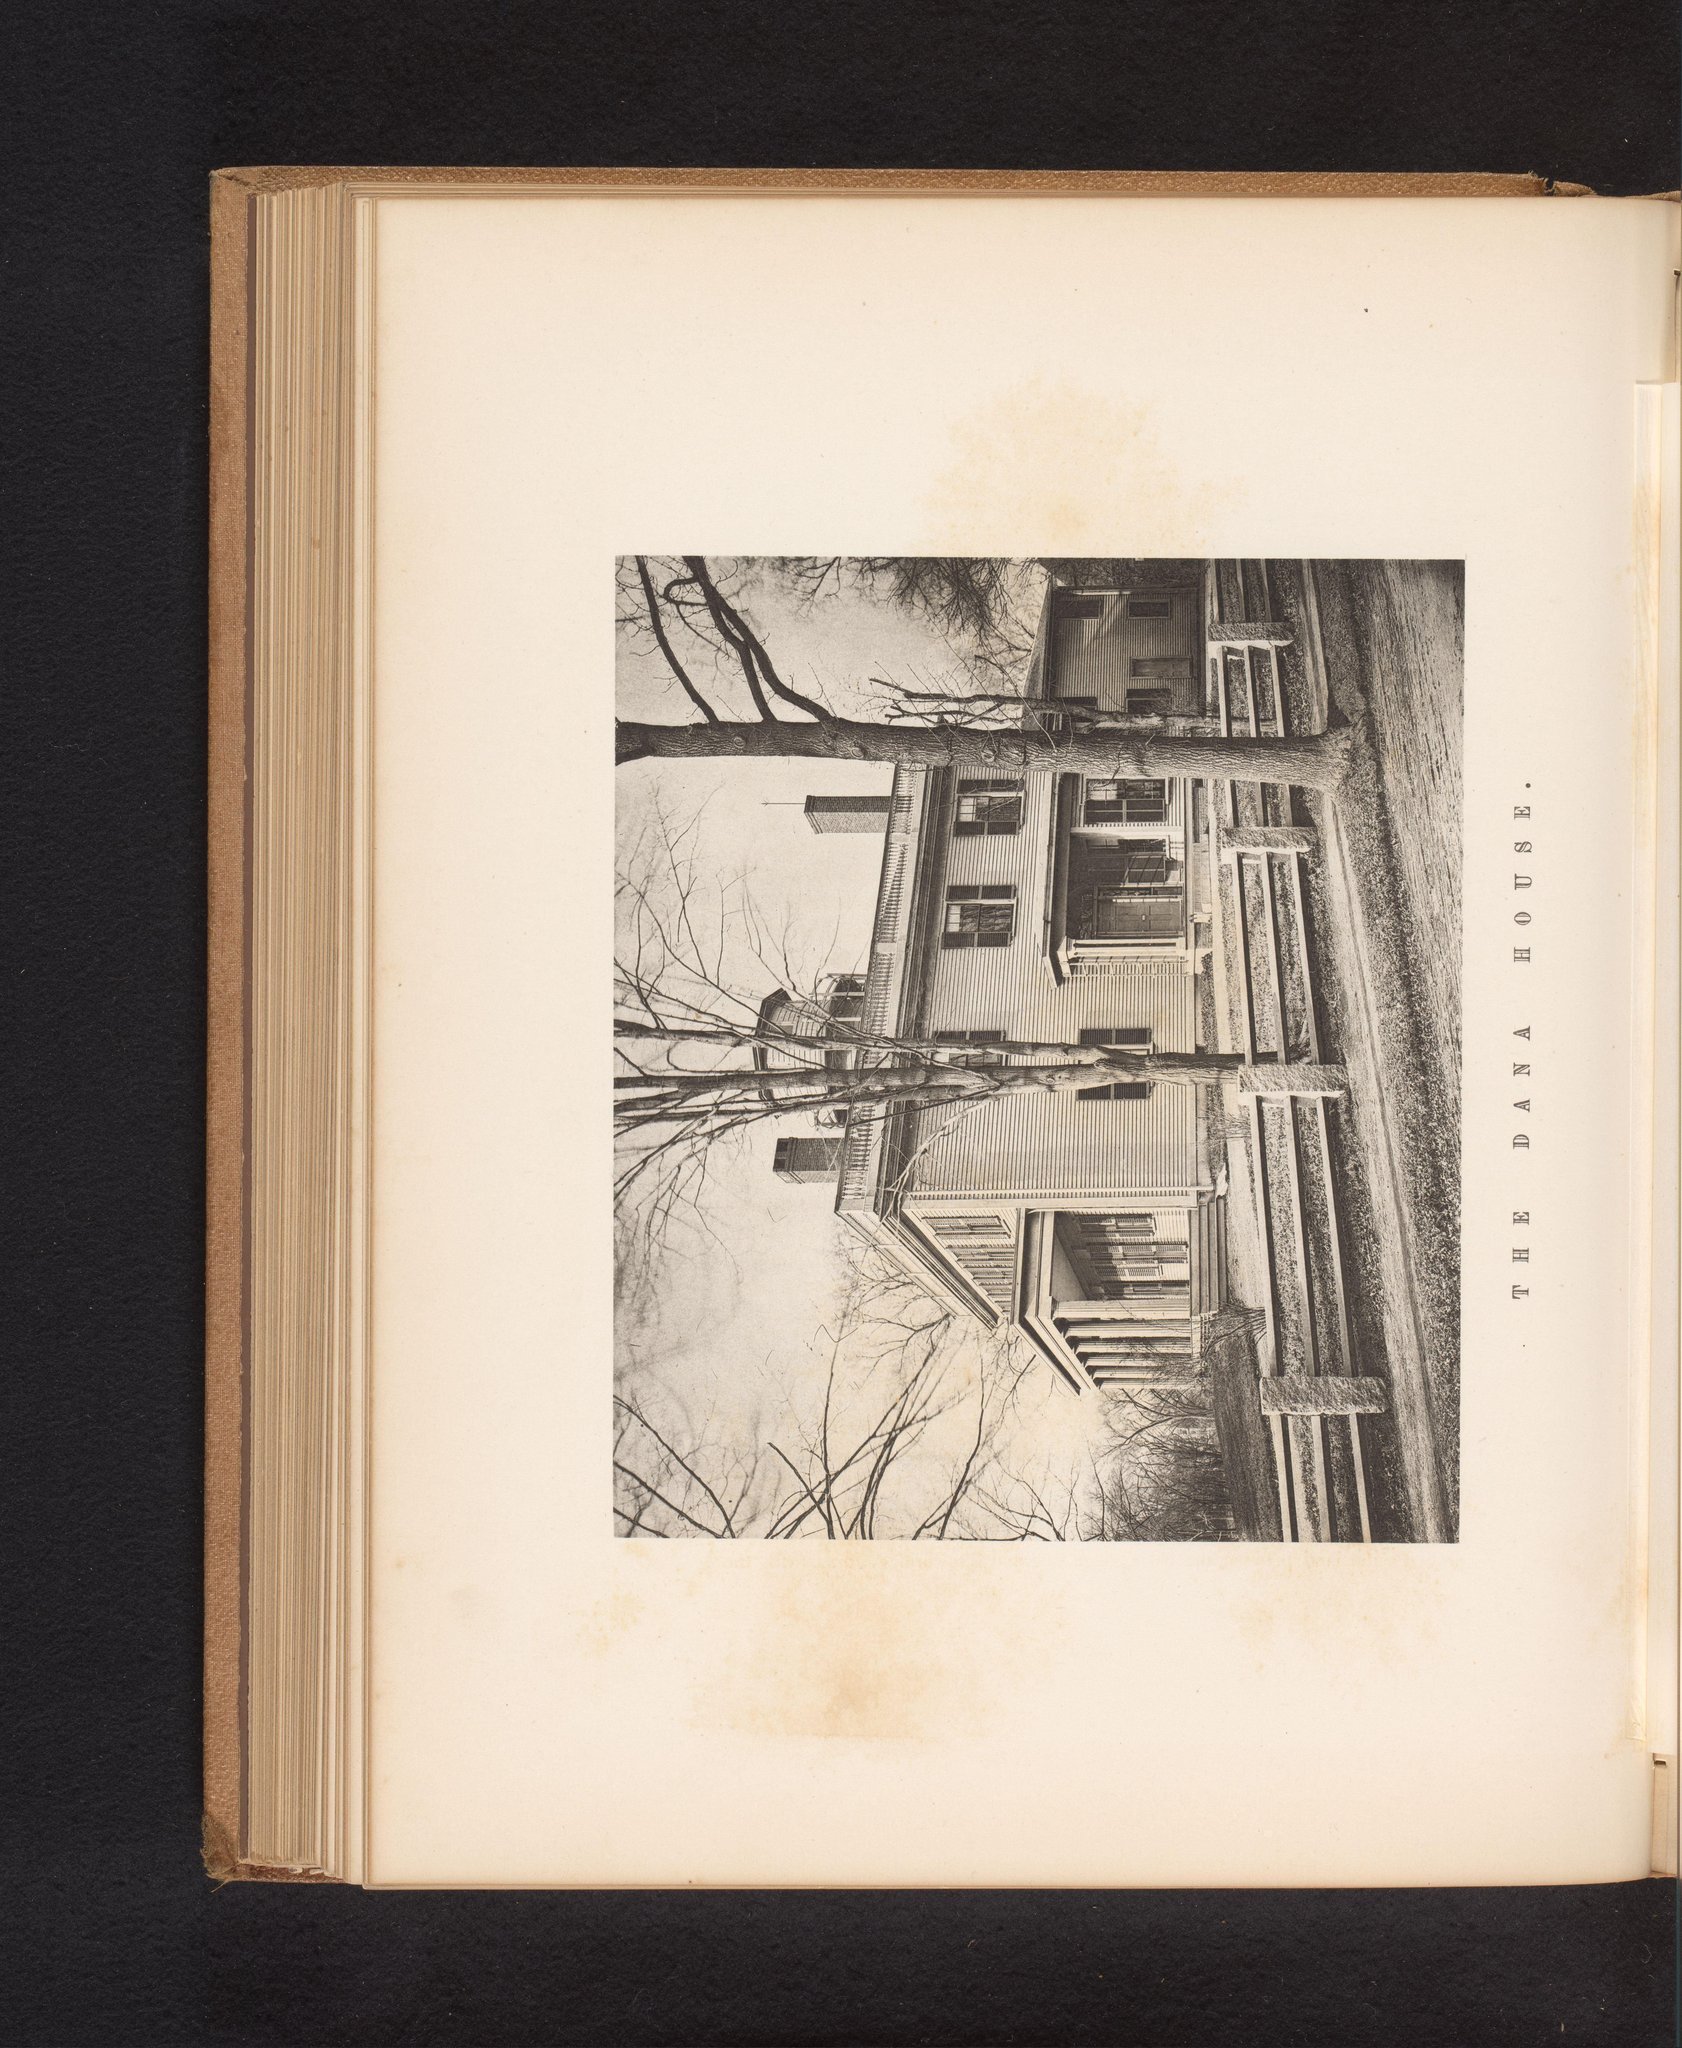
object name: page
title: The Dana House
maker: Anonymous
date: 1870-1875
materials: paper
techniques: photograph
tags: urban housing, university building, college